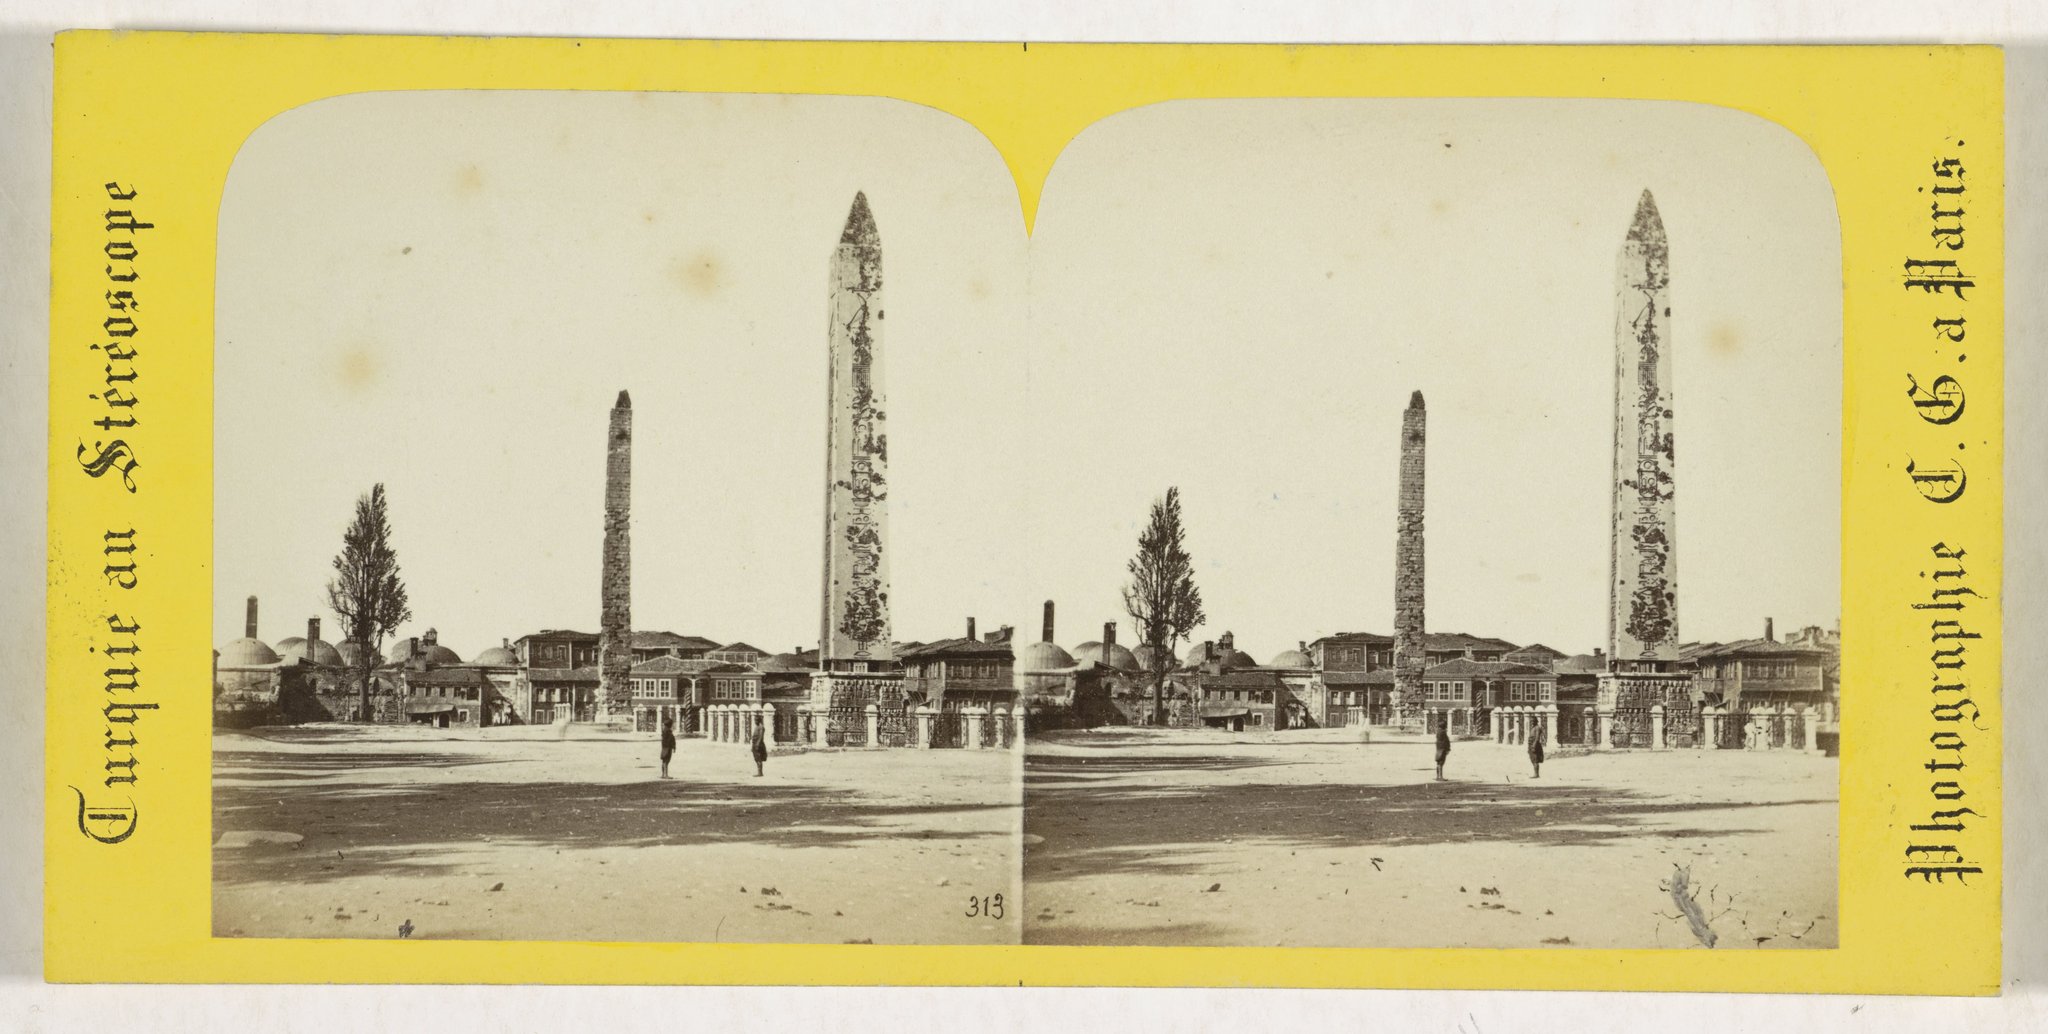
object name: stereograph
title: Sultanahmet Meydani plein in Istanboel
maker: charles gaudin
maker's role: publisher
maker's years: 1825-1905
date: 1861-1870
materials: cardboard, paper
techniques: albumen print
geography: hippodroom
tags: square, place, circus, etc.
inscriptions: number: ‘313’